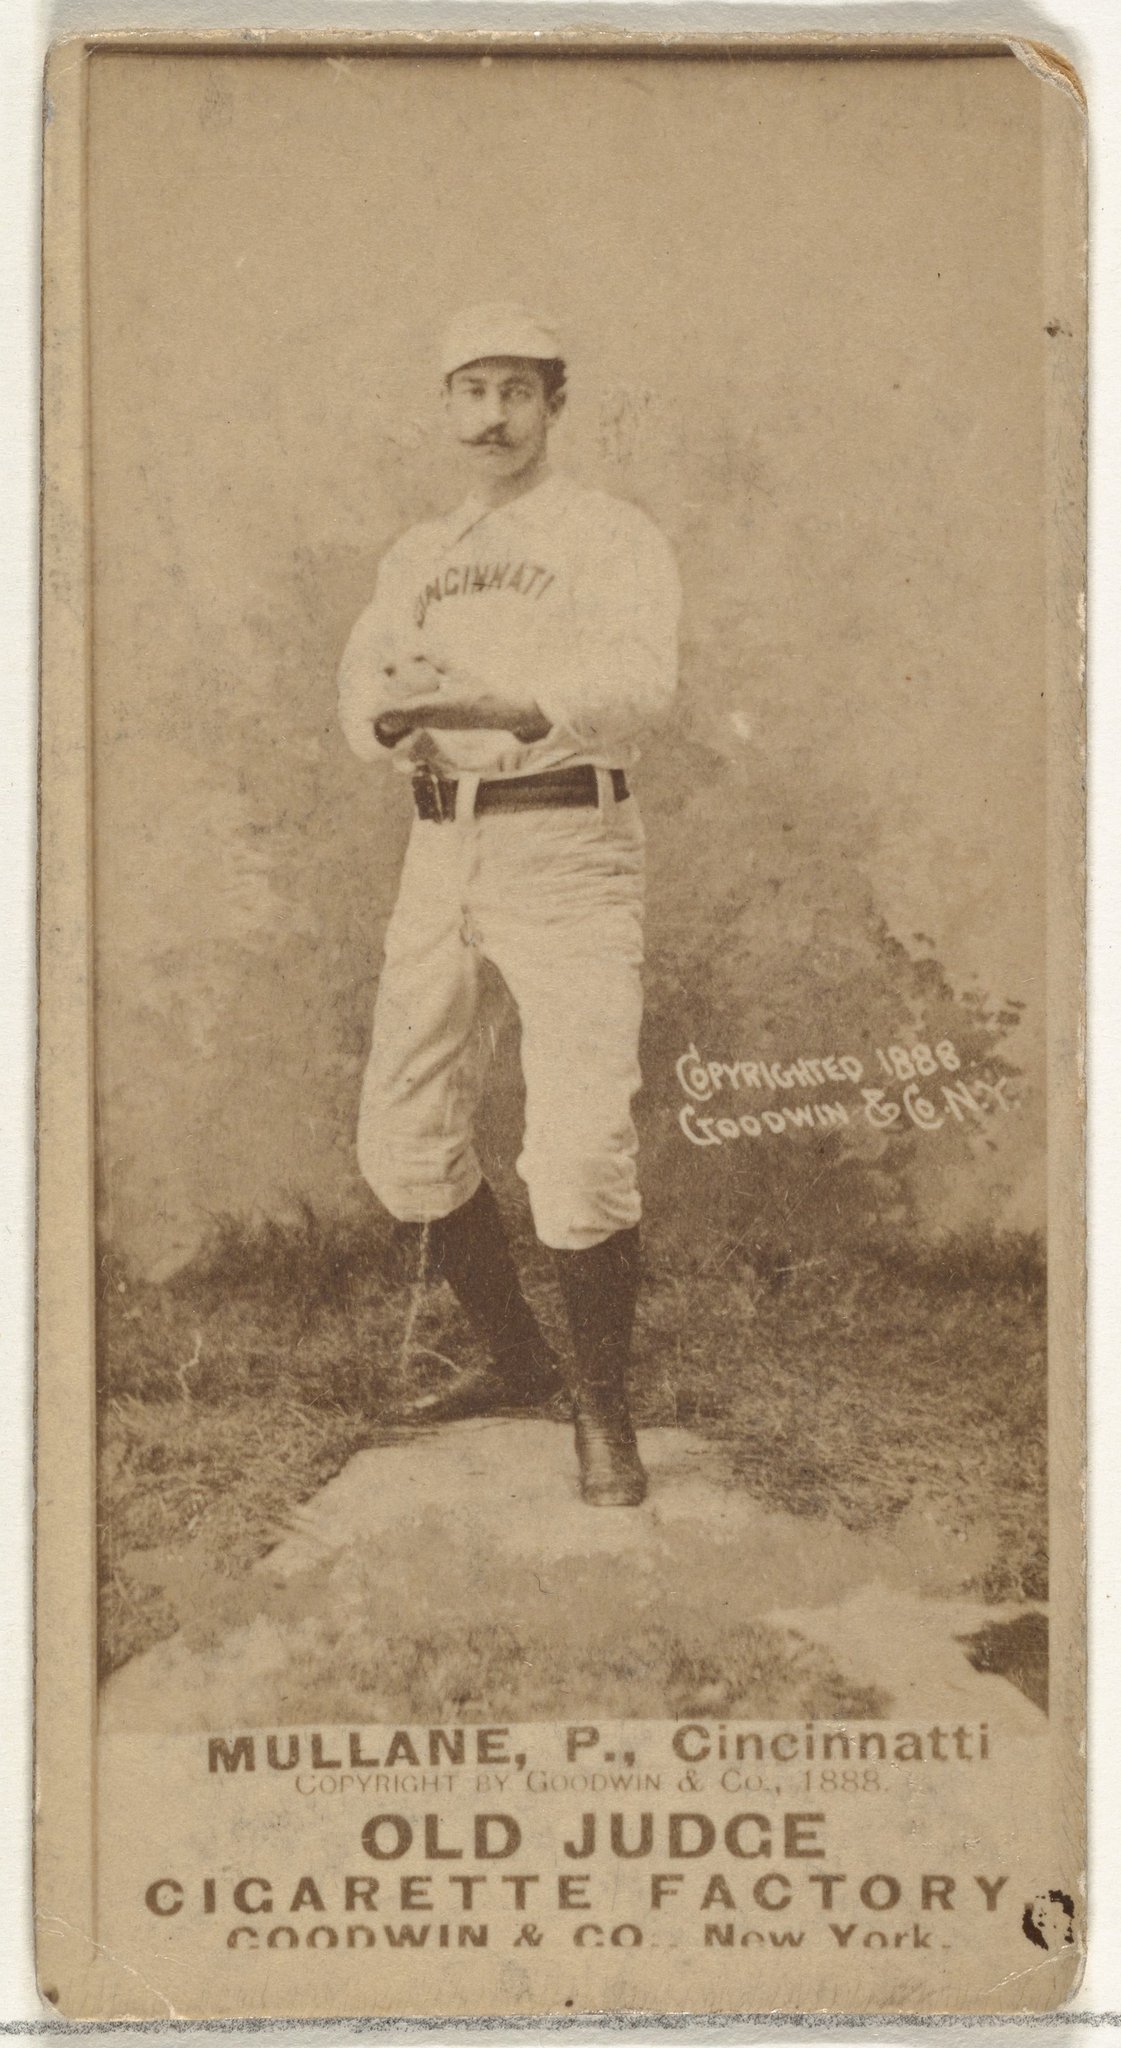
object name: baseball card, photograph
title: Anthony John "Tony" Mullane, Pitcher, Cincinnati, from the Old Judge series (N172) for Old Judge Cigarettes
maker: goodwin & company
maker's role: publisher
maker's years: 1850-1950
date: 1888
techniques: albumen silver print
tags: men,portraits,baseball,athletes